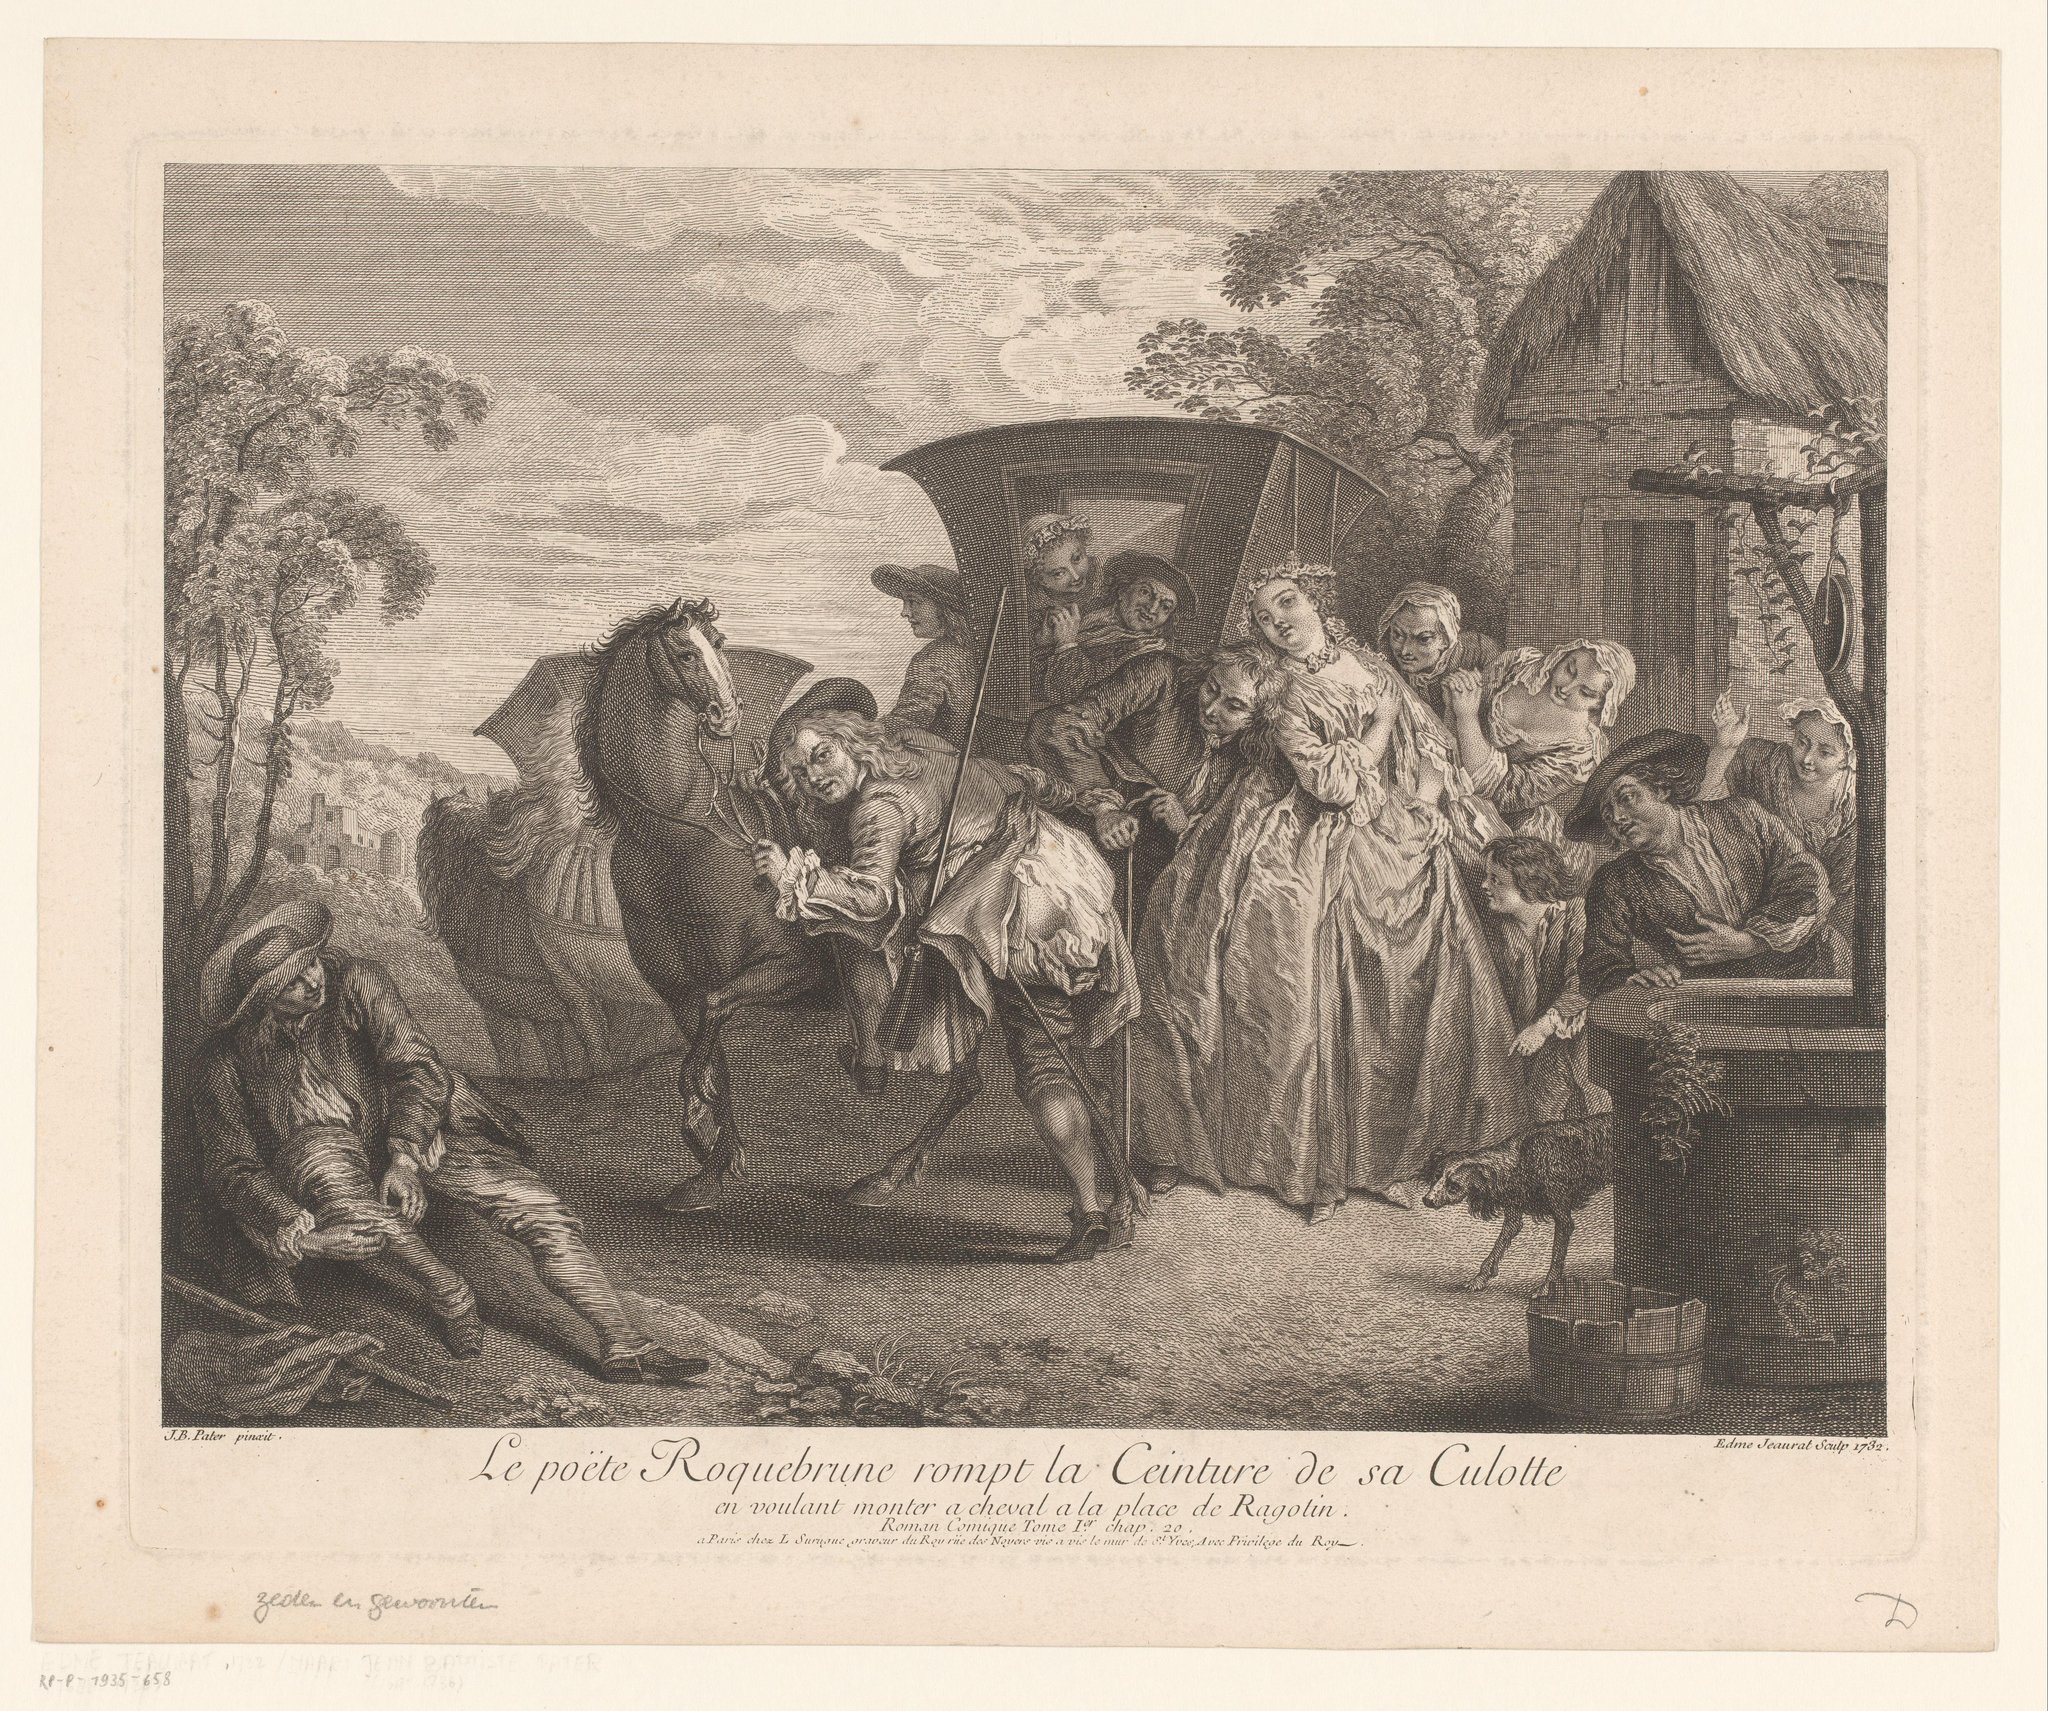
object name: print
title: Toneelscène uit Paul Scarron's Roman Comique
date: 1732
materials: paper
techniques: engraving, etching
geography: paris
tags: (scarron) specific works of literature (with author, title), passenger carriage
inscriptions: collector's mark: Lugt 2228